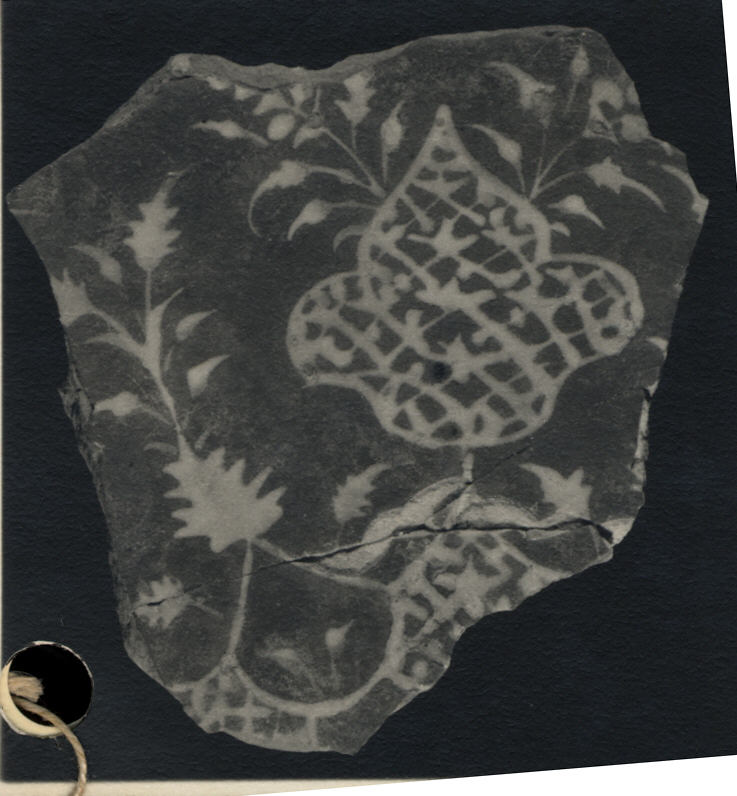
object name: fragment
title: Ceramic Fragment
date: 1301-1400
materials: ceramic glaze, earthenware, glaze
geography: iran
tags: leaves